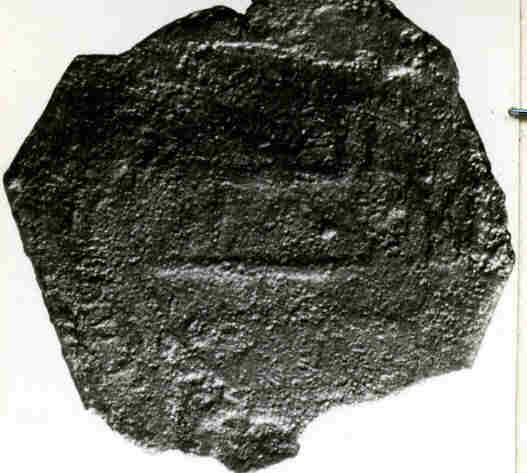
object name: coin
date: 701-900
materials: copper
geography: iran